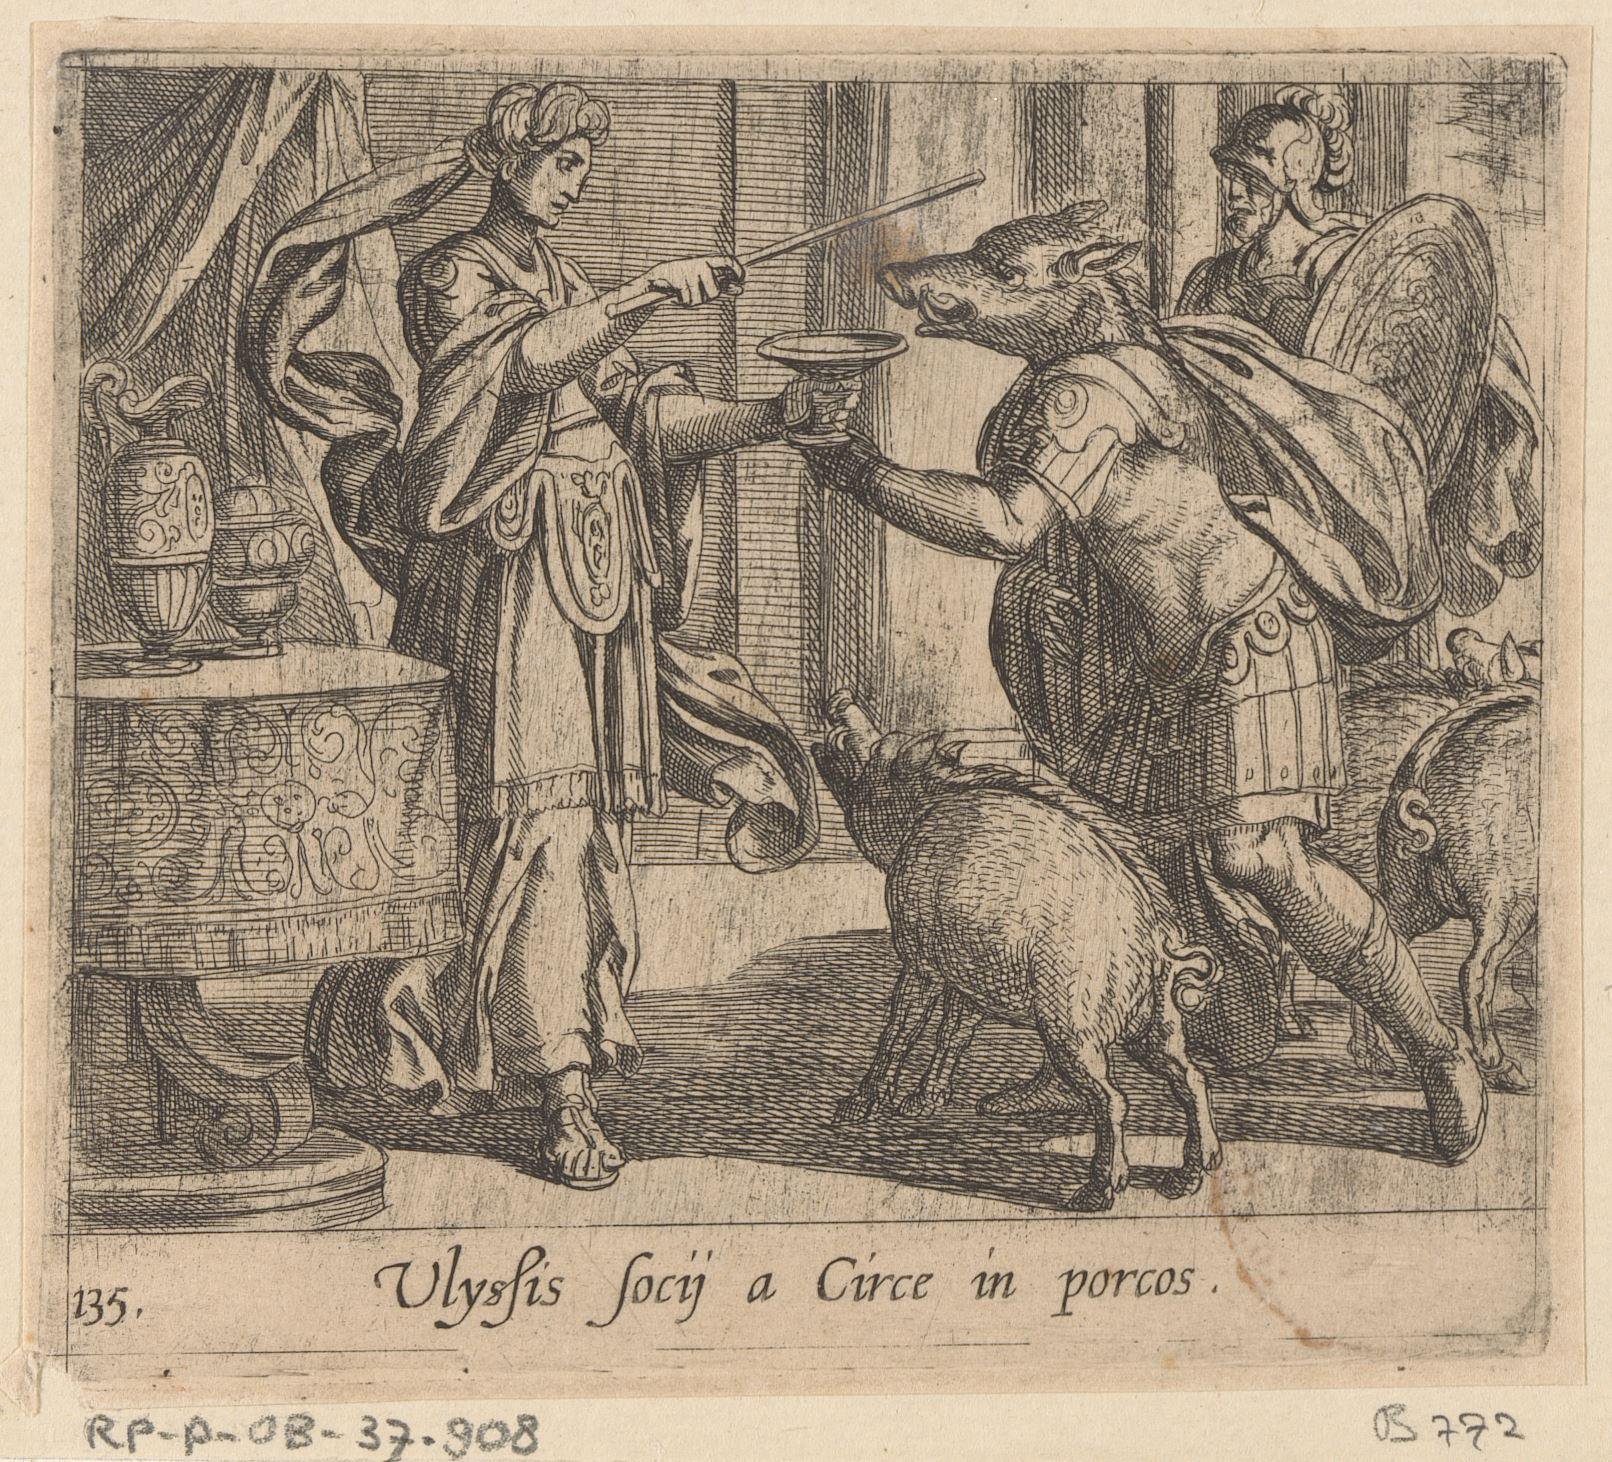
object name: print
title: Circe verandert de mannen van Odysseus in zwijnen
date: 1606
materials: paper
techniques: etching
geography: antwerp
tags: ulysses' companions changed into swine: when they drink from the cup offered by circe, the enchantress, ulysses' companions change into swine (ovid, metamorphoses xiv 276)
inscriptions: collector's mark: Lugt 240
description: Deze prent maakt deel uit van een reeks van 150 prenten (+ titelprent) met voorstellingen van de Metamorfosen van Ovidius.